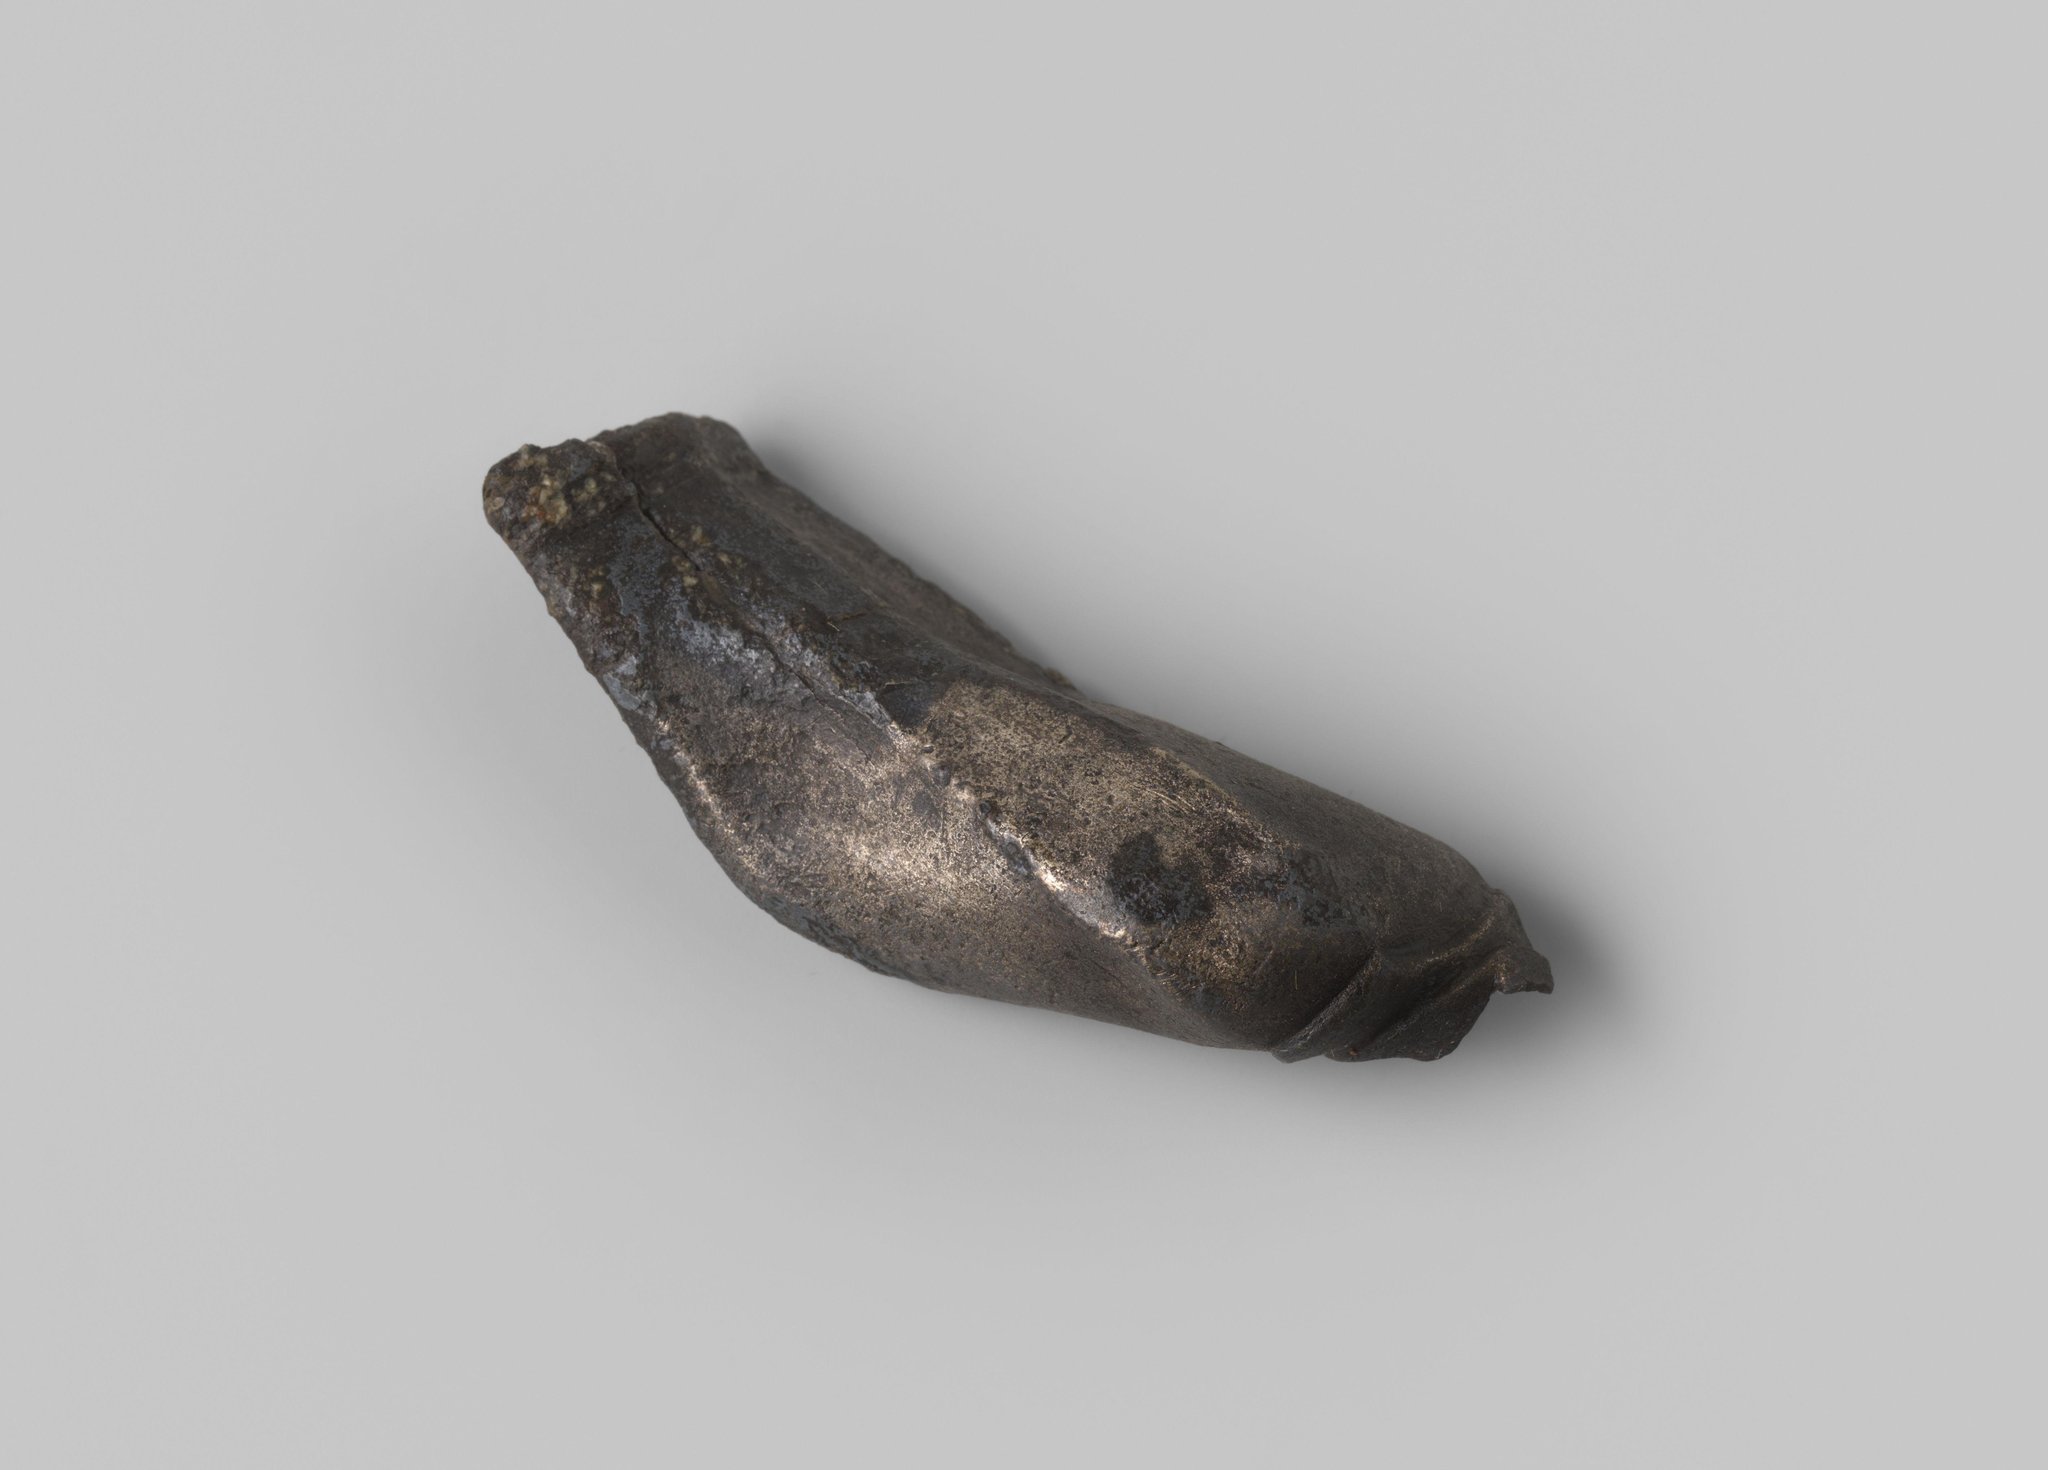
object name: candlestick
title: Fragment steel van een kandelaar uit het wrak van de Oost-Indiëvaarder Hollandia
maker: Anonymous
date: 1700-1743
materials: silver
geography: netherlands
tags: verenigde oostindische compagnie, hollandia (schip), annet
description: Candlestick, stem; fragm of baluster, id. NG 1980-27H2873.